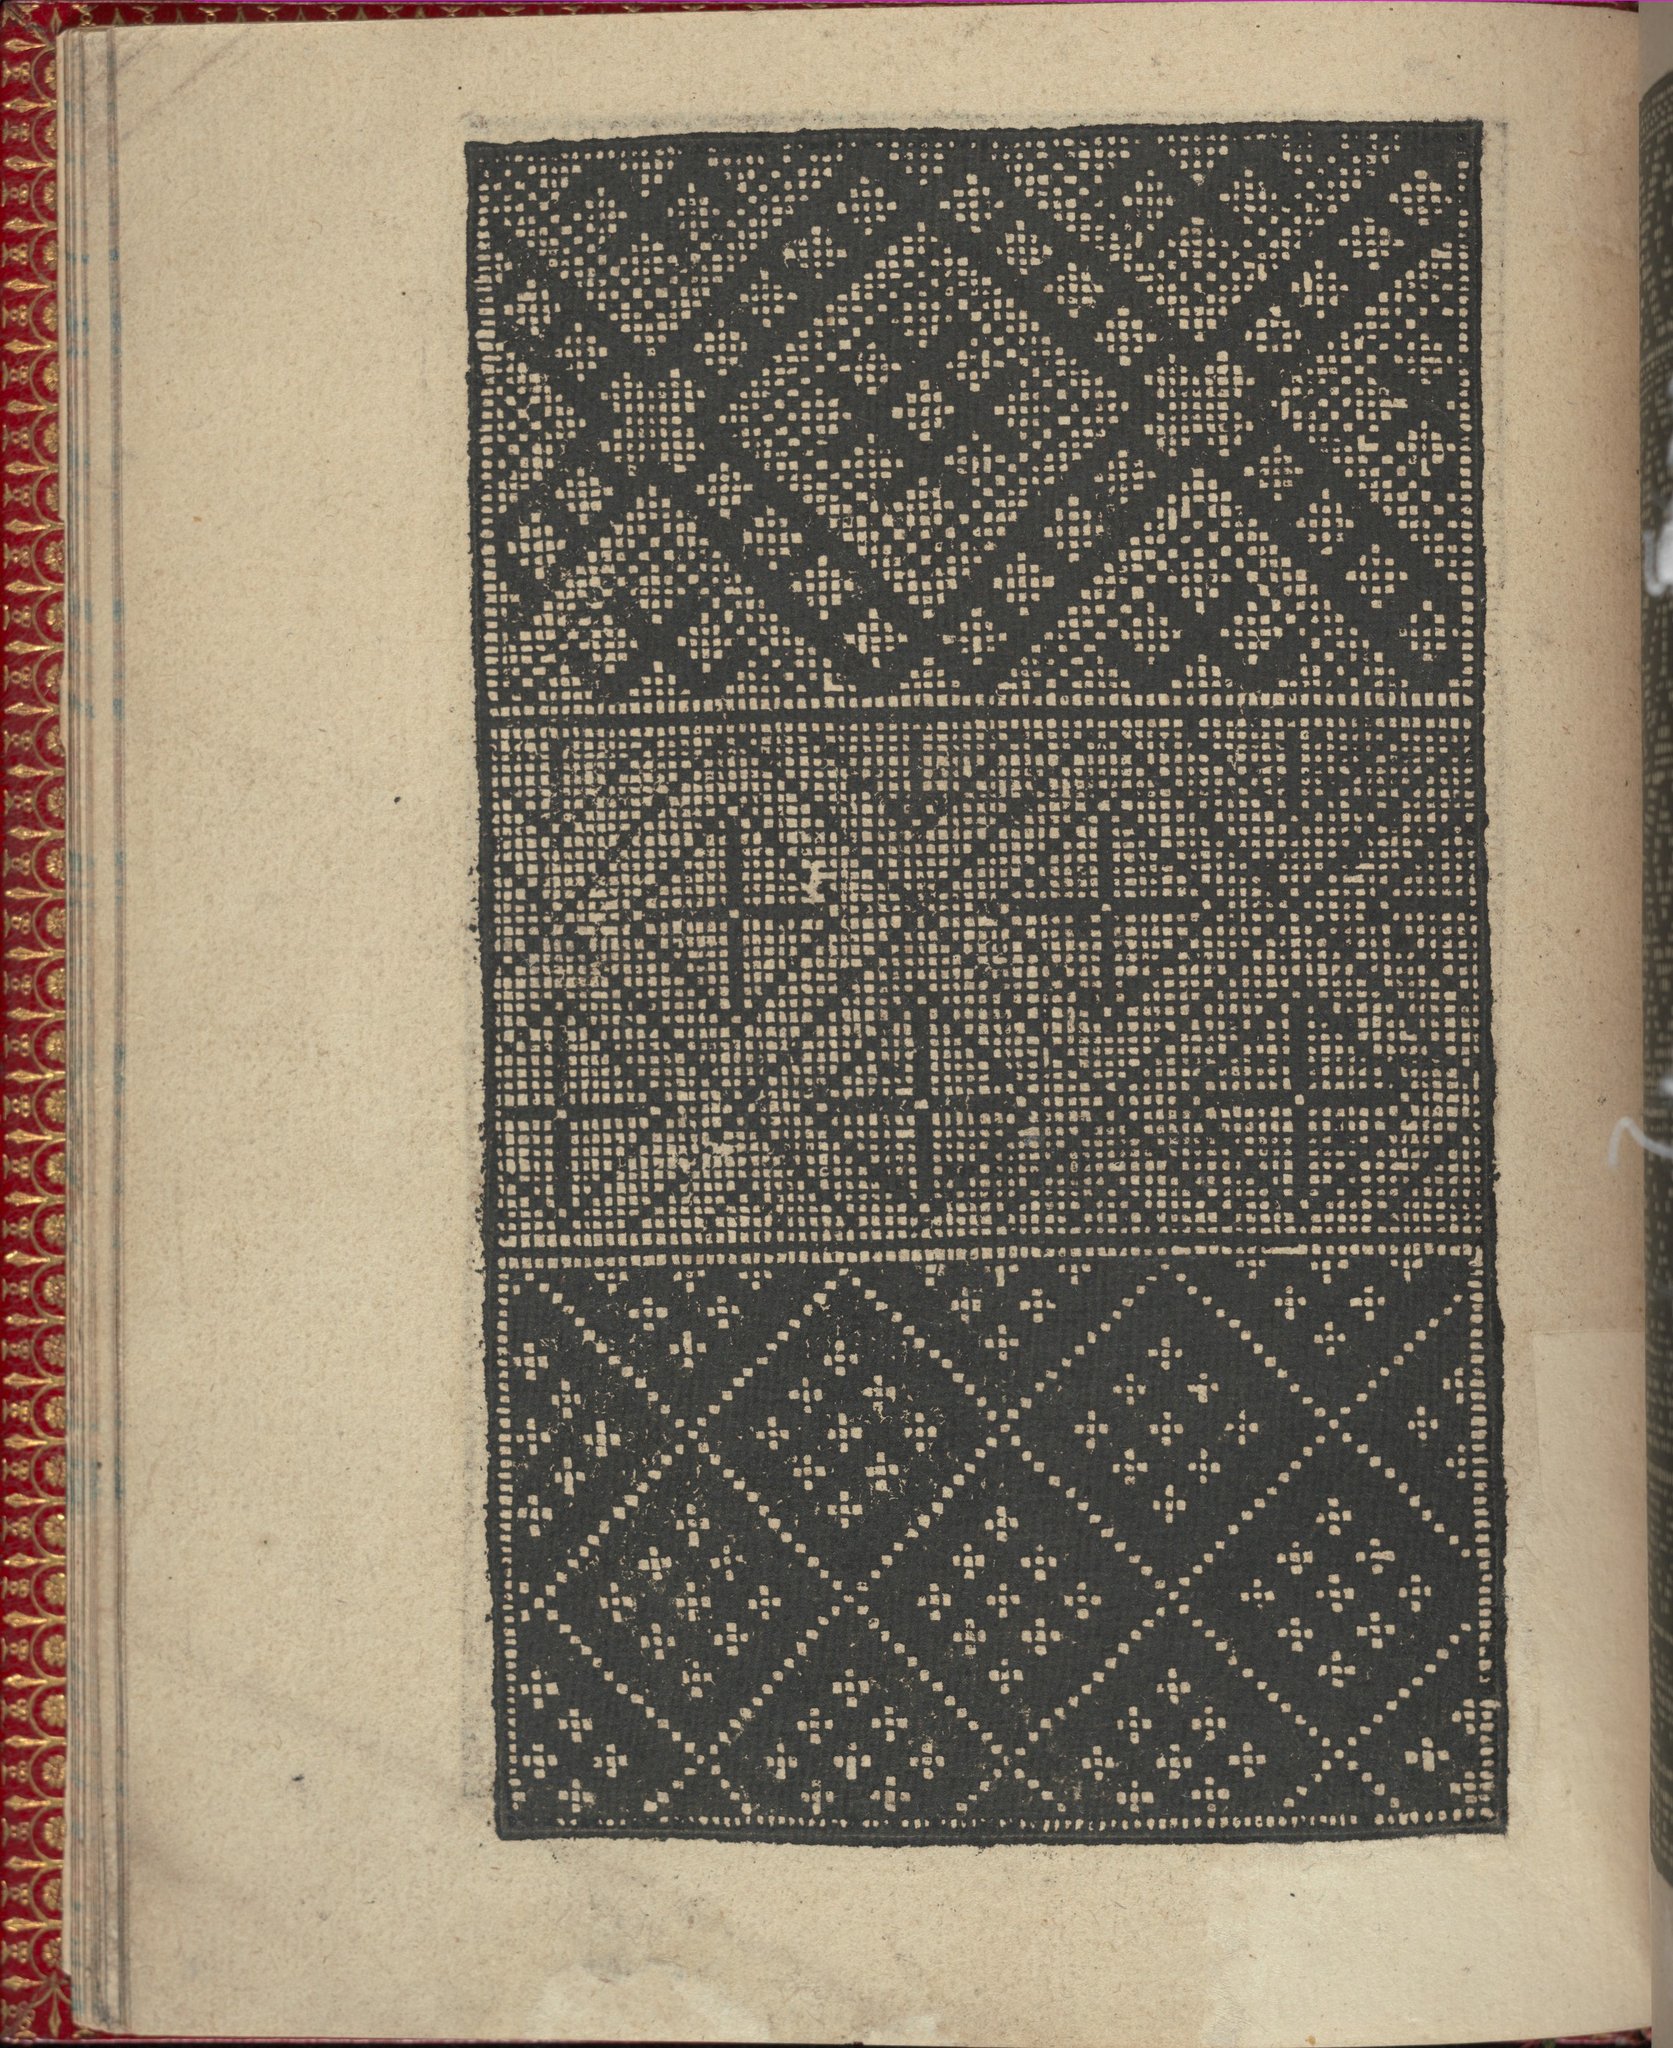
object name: book print ornament architecture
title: Ce est ung tractat de la noble art de leguille ascavoir ouvraiges de spaigne... page 9 (verso)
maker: willem vosterman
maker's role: printer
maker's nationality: netherlandish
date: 1527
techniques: woodcut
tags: ornament